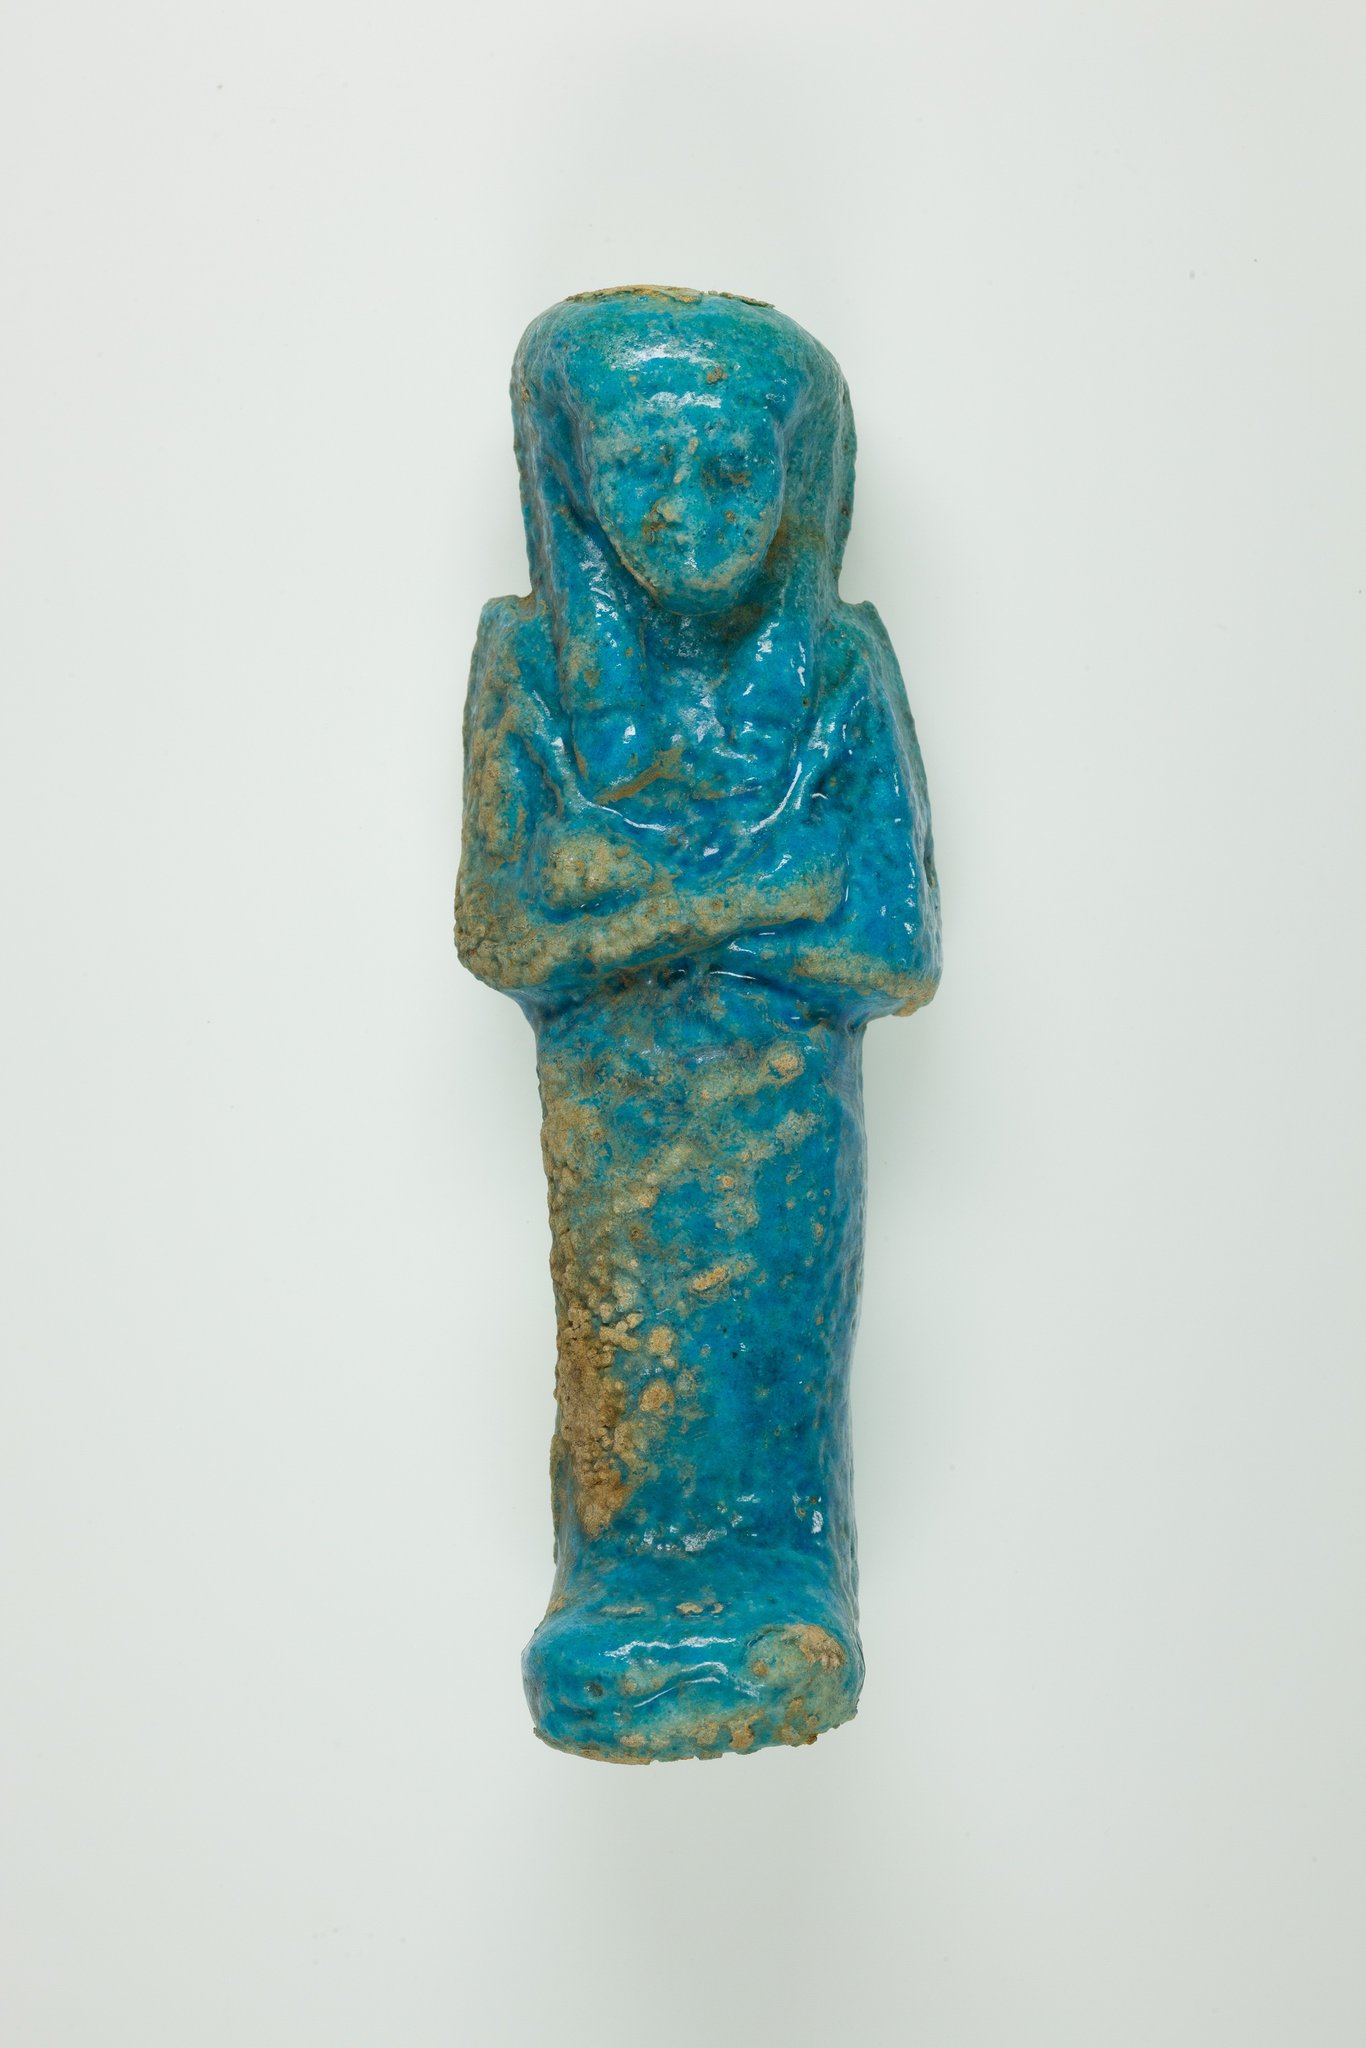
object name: worker shabti, henettawy c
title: Worker Shabti of Henettawy (C), Daughter of Isetemkheb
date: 990-970 BCE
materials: faience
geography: egypt